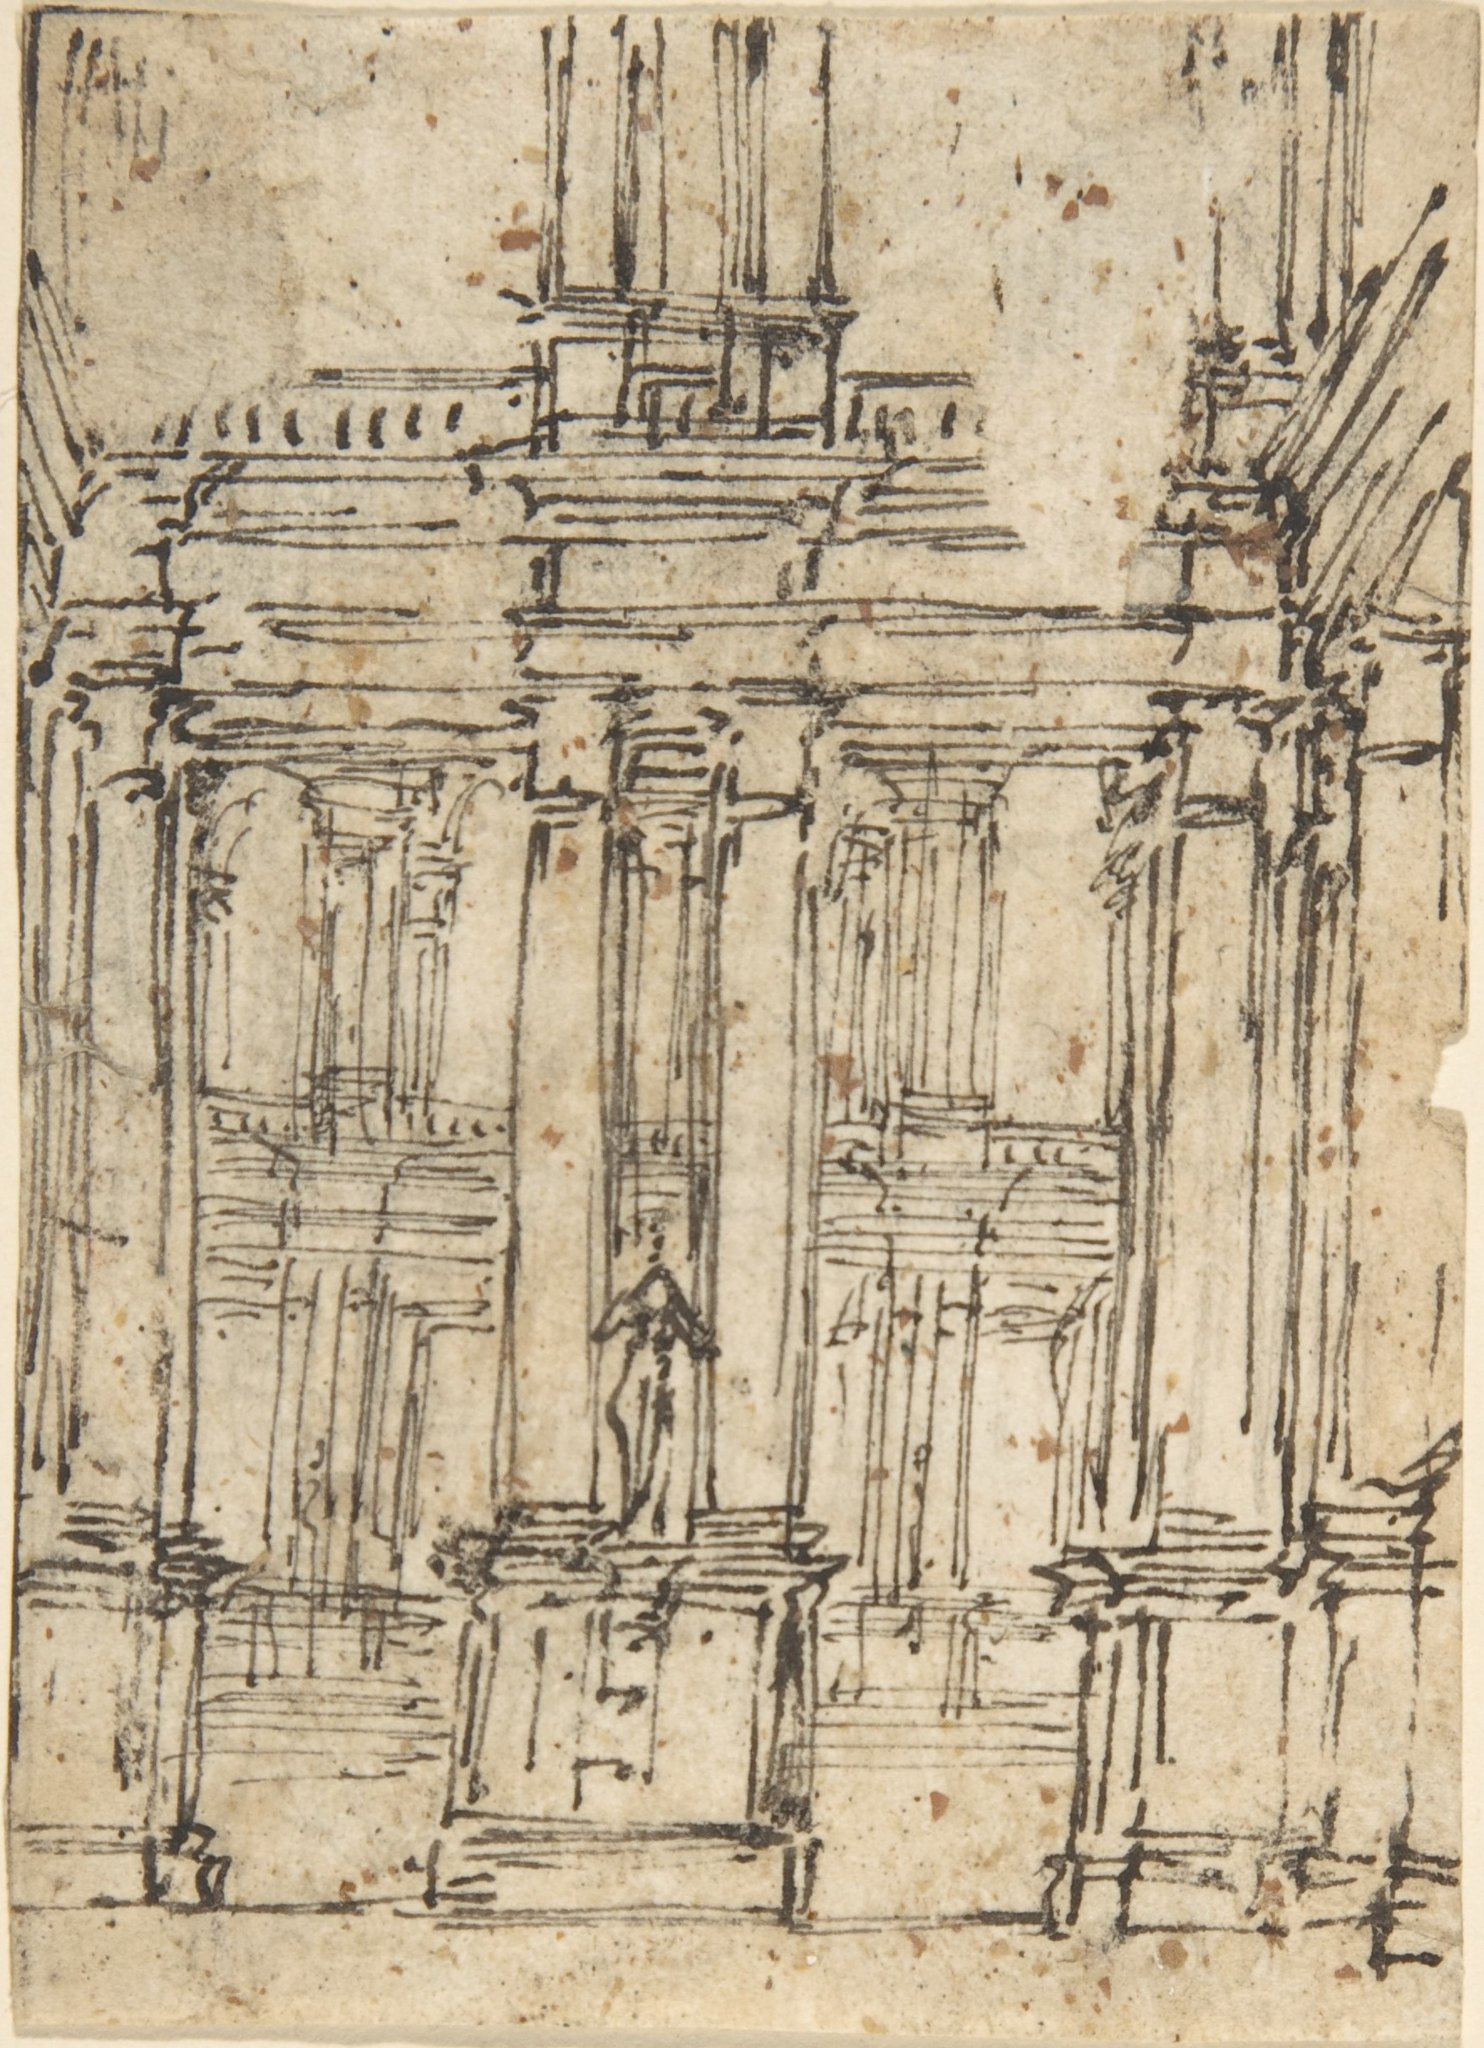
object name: drawing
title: Architectural Drawing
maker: anonymous, italian, 18th century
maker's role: artist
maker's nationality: italian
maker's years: 1700-1800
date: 1701-1800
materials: chalk, ink, paper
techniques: pen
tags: architecture,columns